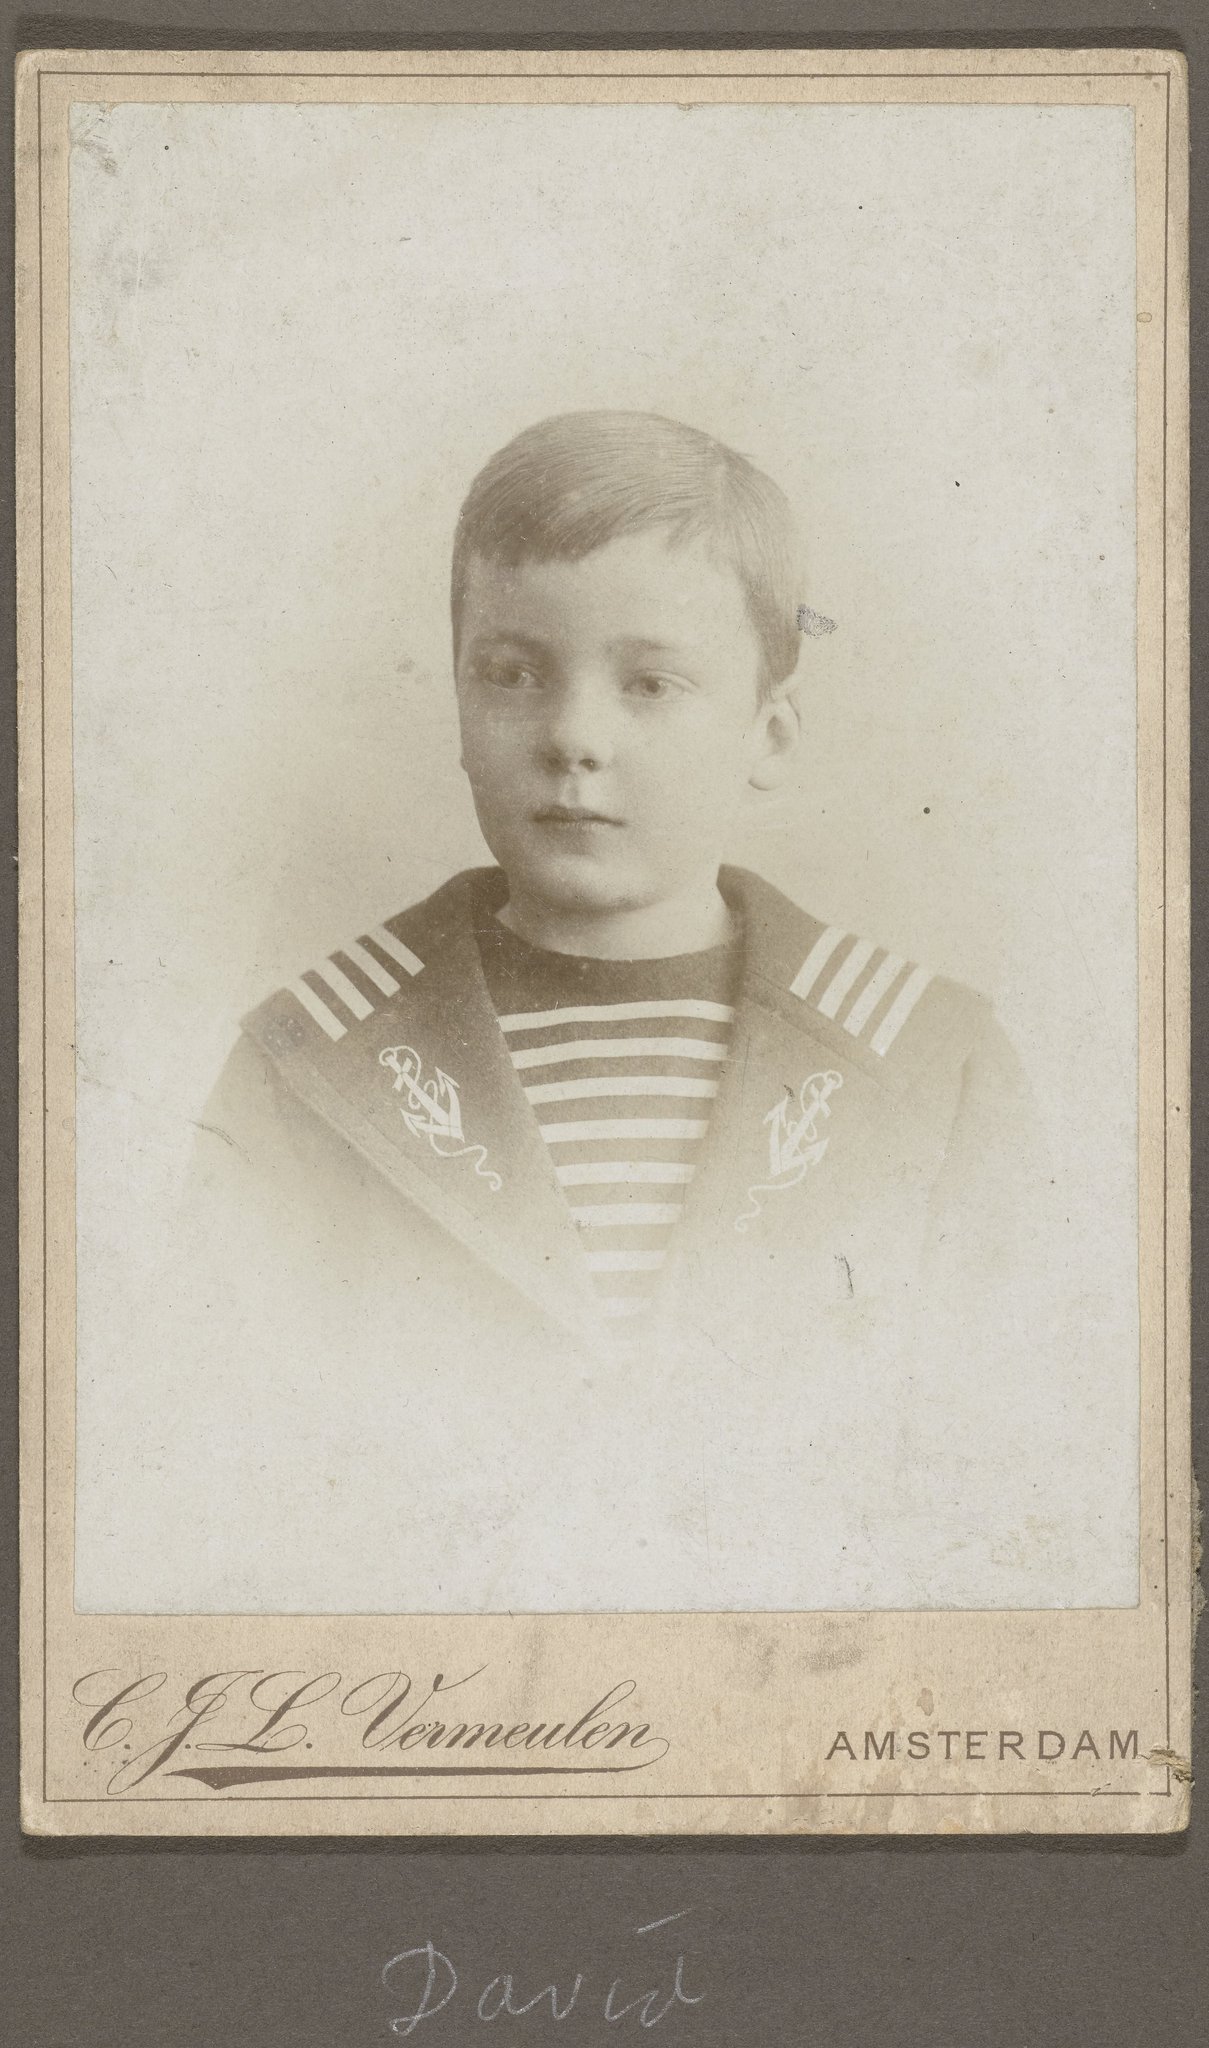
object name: photograph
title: Portret van David Vermeulen in een matrozenpak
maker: cornelis johannes lodewicus vermeulen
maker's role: fotograaf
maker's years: 1861-1936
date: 1888-1896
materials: paper, cardboard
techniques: collodion silver print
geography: amsterdam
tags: boy (child between toddler and youth), historical persons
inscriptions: name: ‘david’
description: Op de revers van het jasje zijn ankers geborduurd.